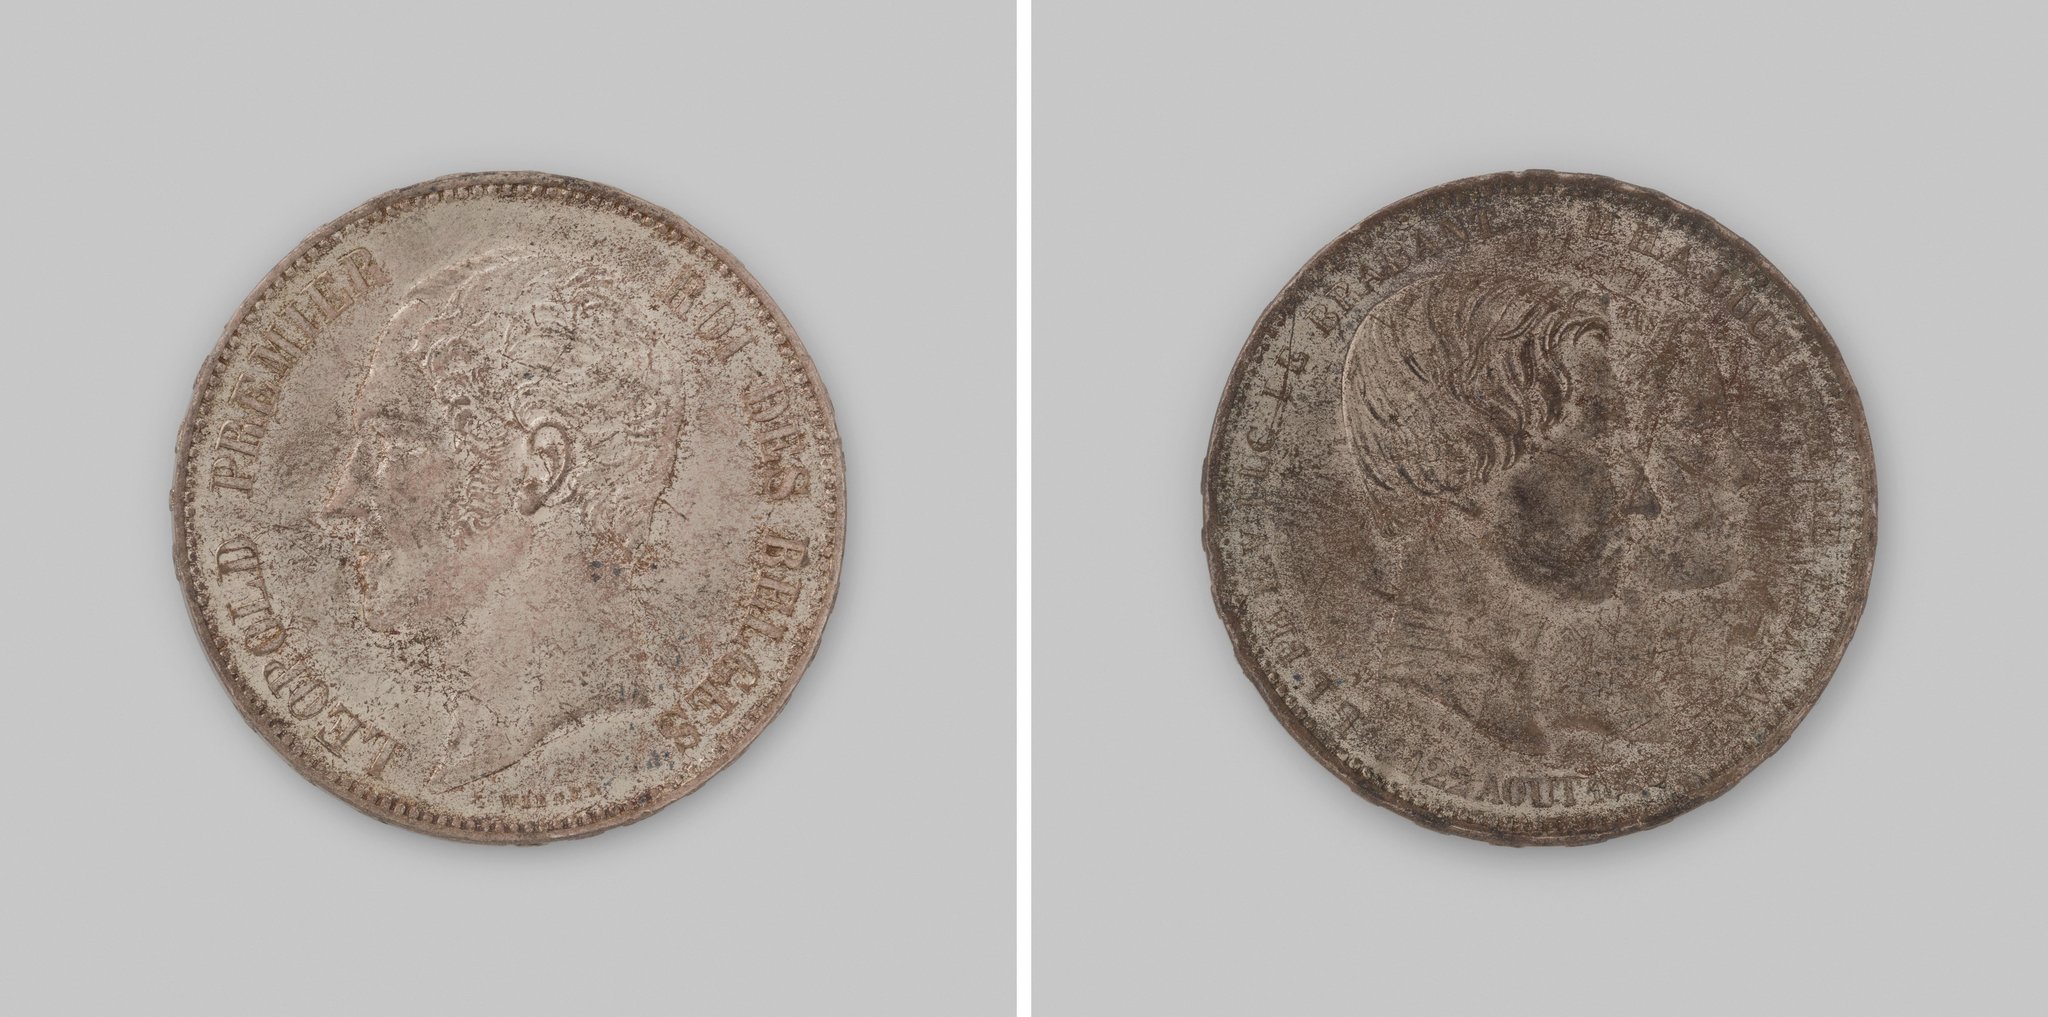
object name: history medal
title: Huwelijk van Leopold Lodewijk Filips Marie Victor, erfprins der Belgen en Marie-Henriette, prinses van Oostenrijk, ter ere van Leopold I, koning der Belgen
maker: leopold wiener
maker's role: sculptor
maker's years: 1823-1891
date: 1853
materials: silver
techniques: striking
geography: brussels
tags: leopold ii (koning der belgen), laeken, leopold i (koning der belgen)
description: Zilveren penning. Voorzijde: borststuk man binnen omschrift. Keerzijde: borststuk man en vrouw binnen omschrift